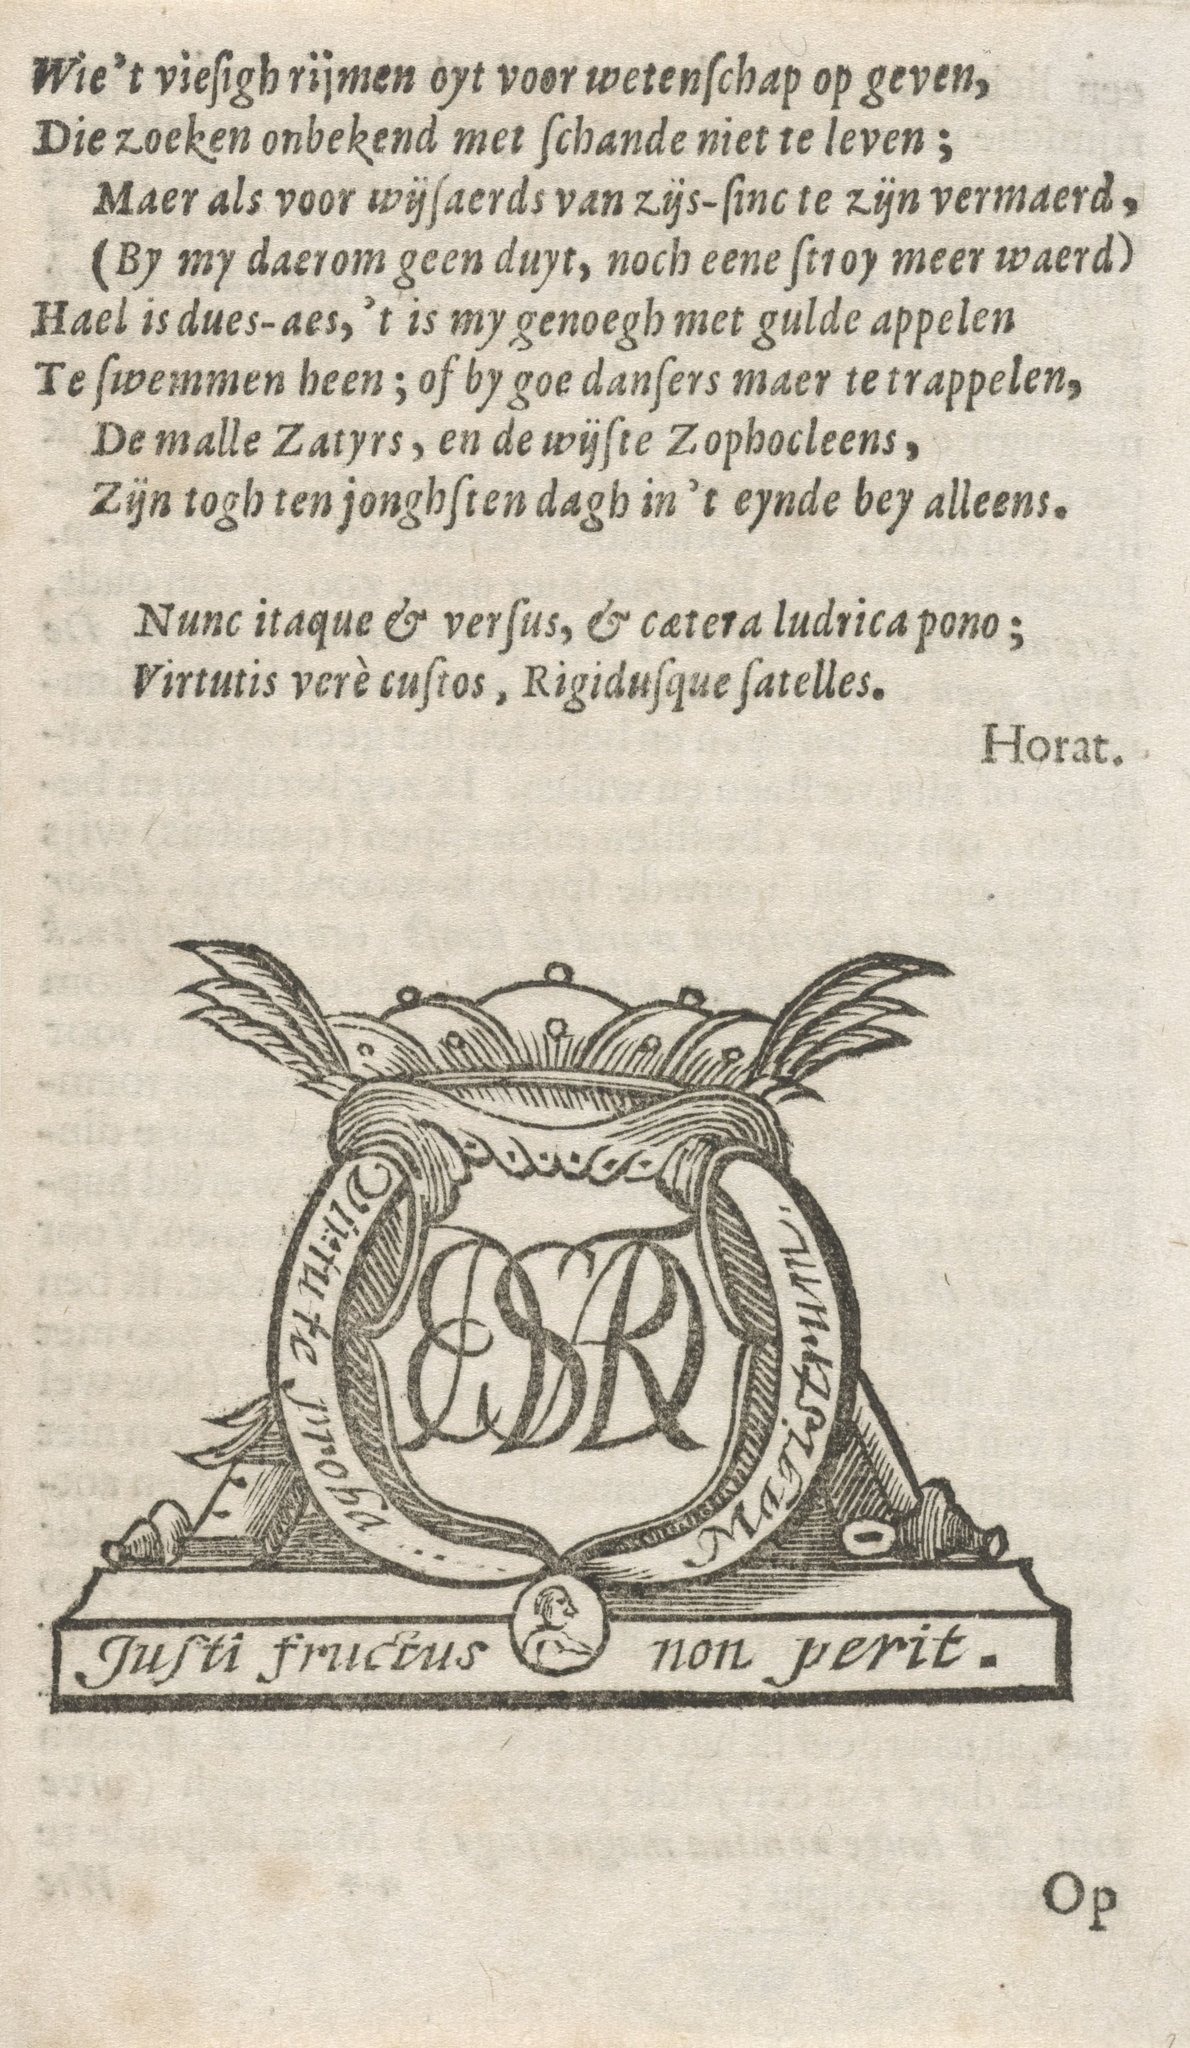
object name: print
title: Monogram van Everhard Meyster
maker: everard meyster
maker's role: print maker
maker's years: 1617-1679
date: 1630-1679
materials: paper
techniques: woodcut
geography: utrecht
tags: letter combinations such as letterword, anagram, letter square, monogram, etc.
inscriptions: collector's mark: Lugt 2228, collector's mark: Lugt 2760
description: Het monogram van schrijver Everhard Meyster met zijn motto in het Latijn. Op recto en verso tekst. Blad uit één van de boeken van Everhard Meyster.